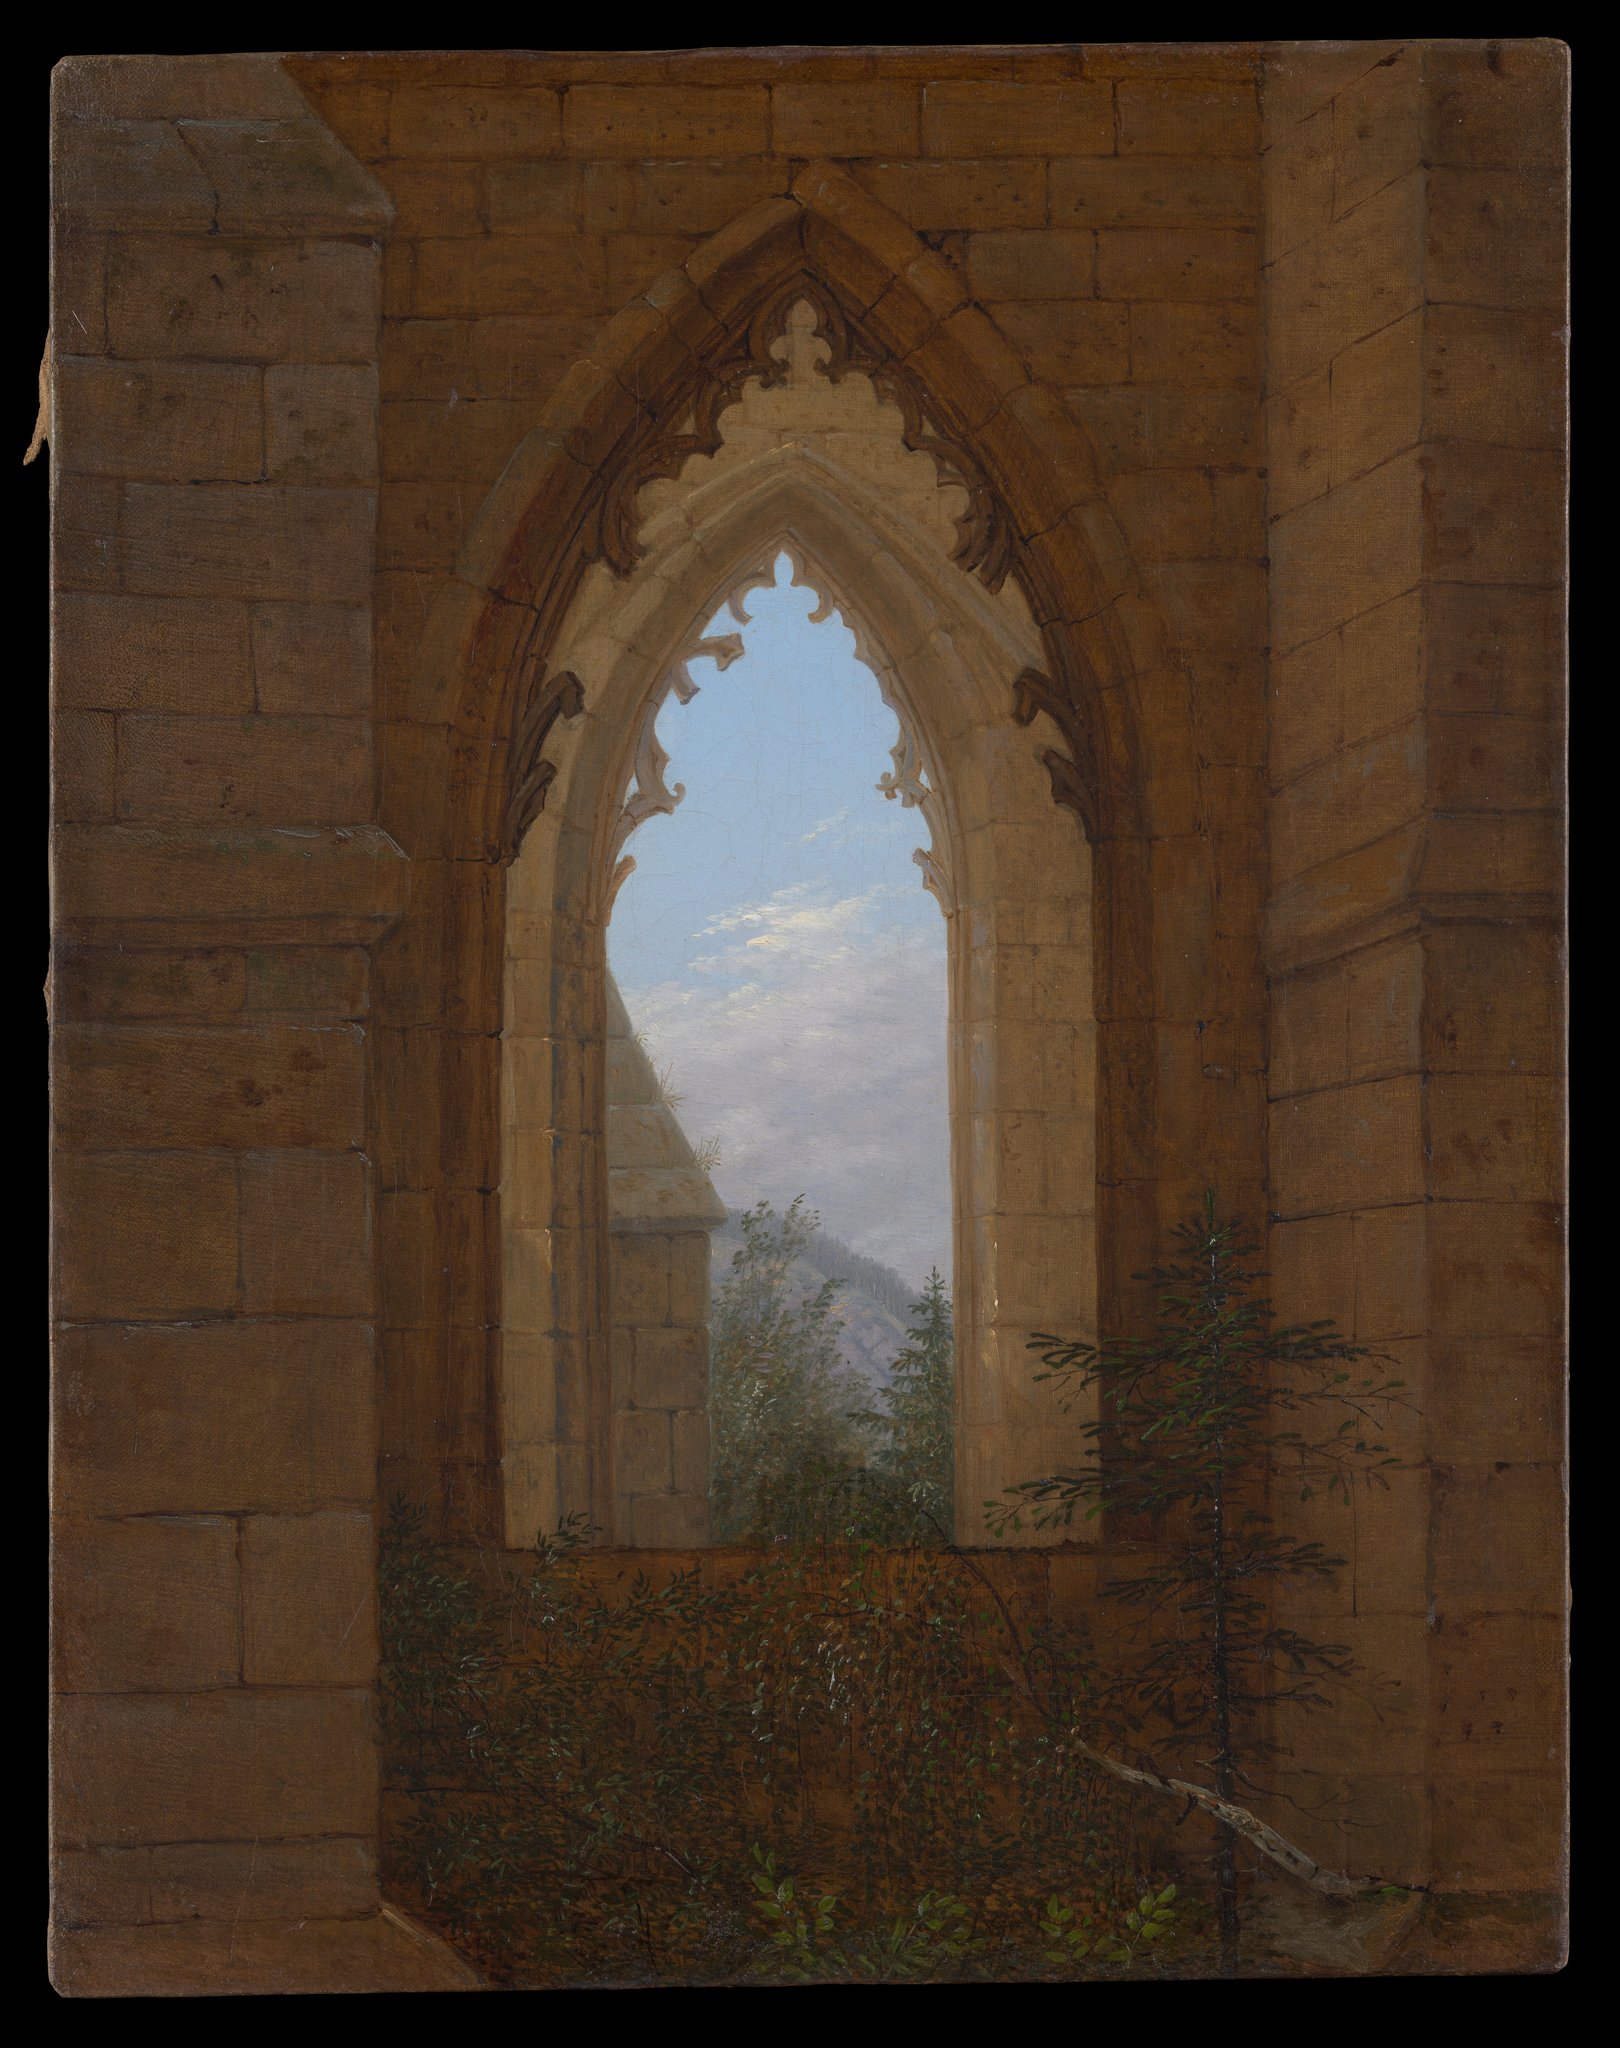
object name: painting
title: Gothic Windows in the Ruins of the Monastery at Oybin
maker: carl gustav carus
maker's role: artist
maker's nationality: german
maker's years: 1789-1869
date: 1828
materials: canvas, oil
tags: windows